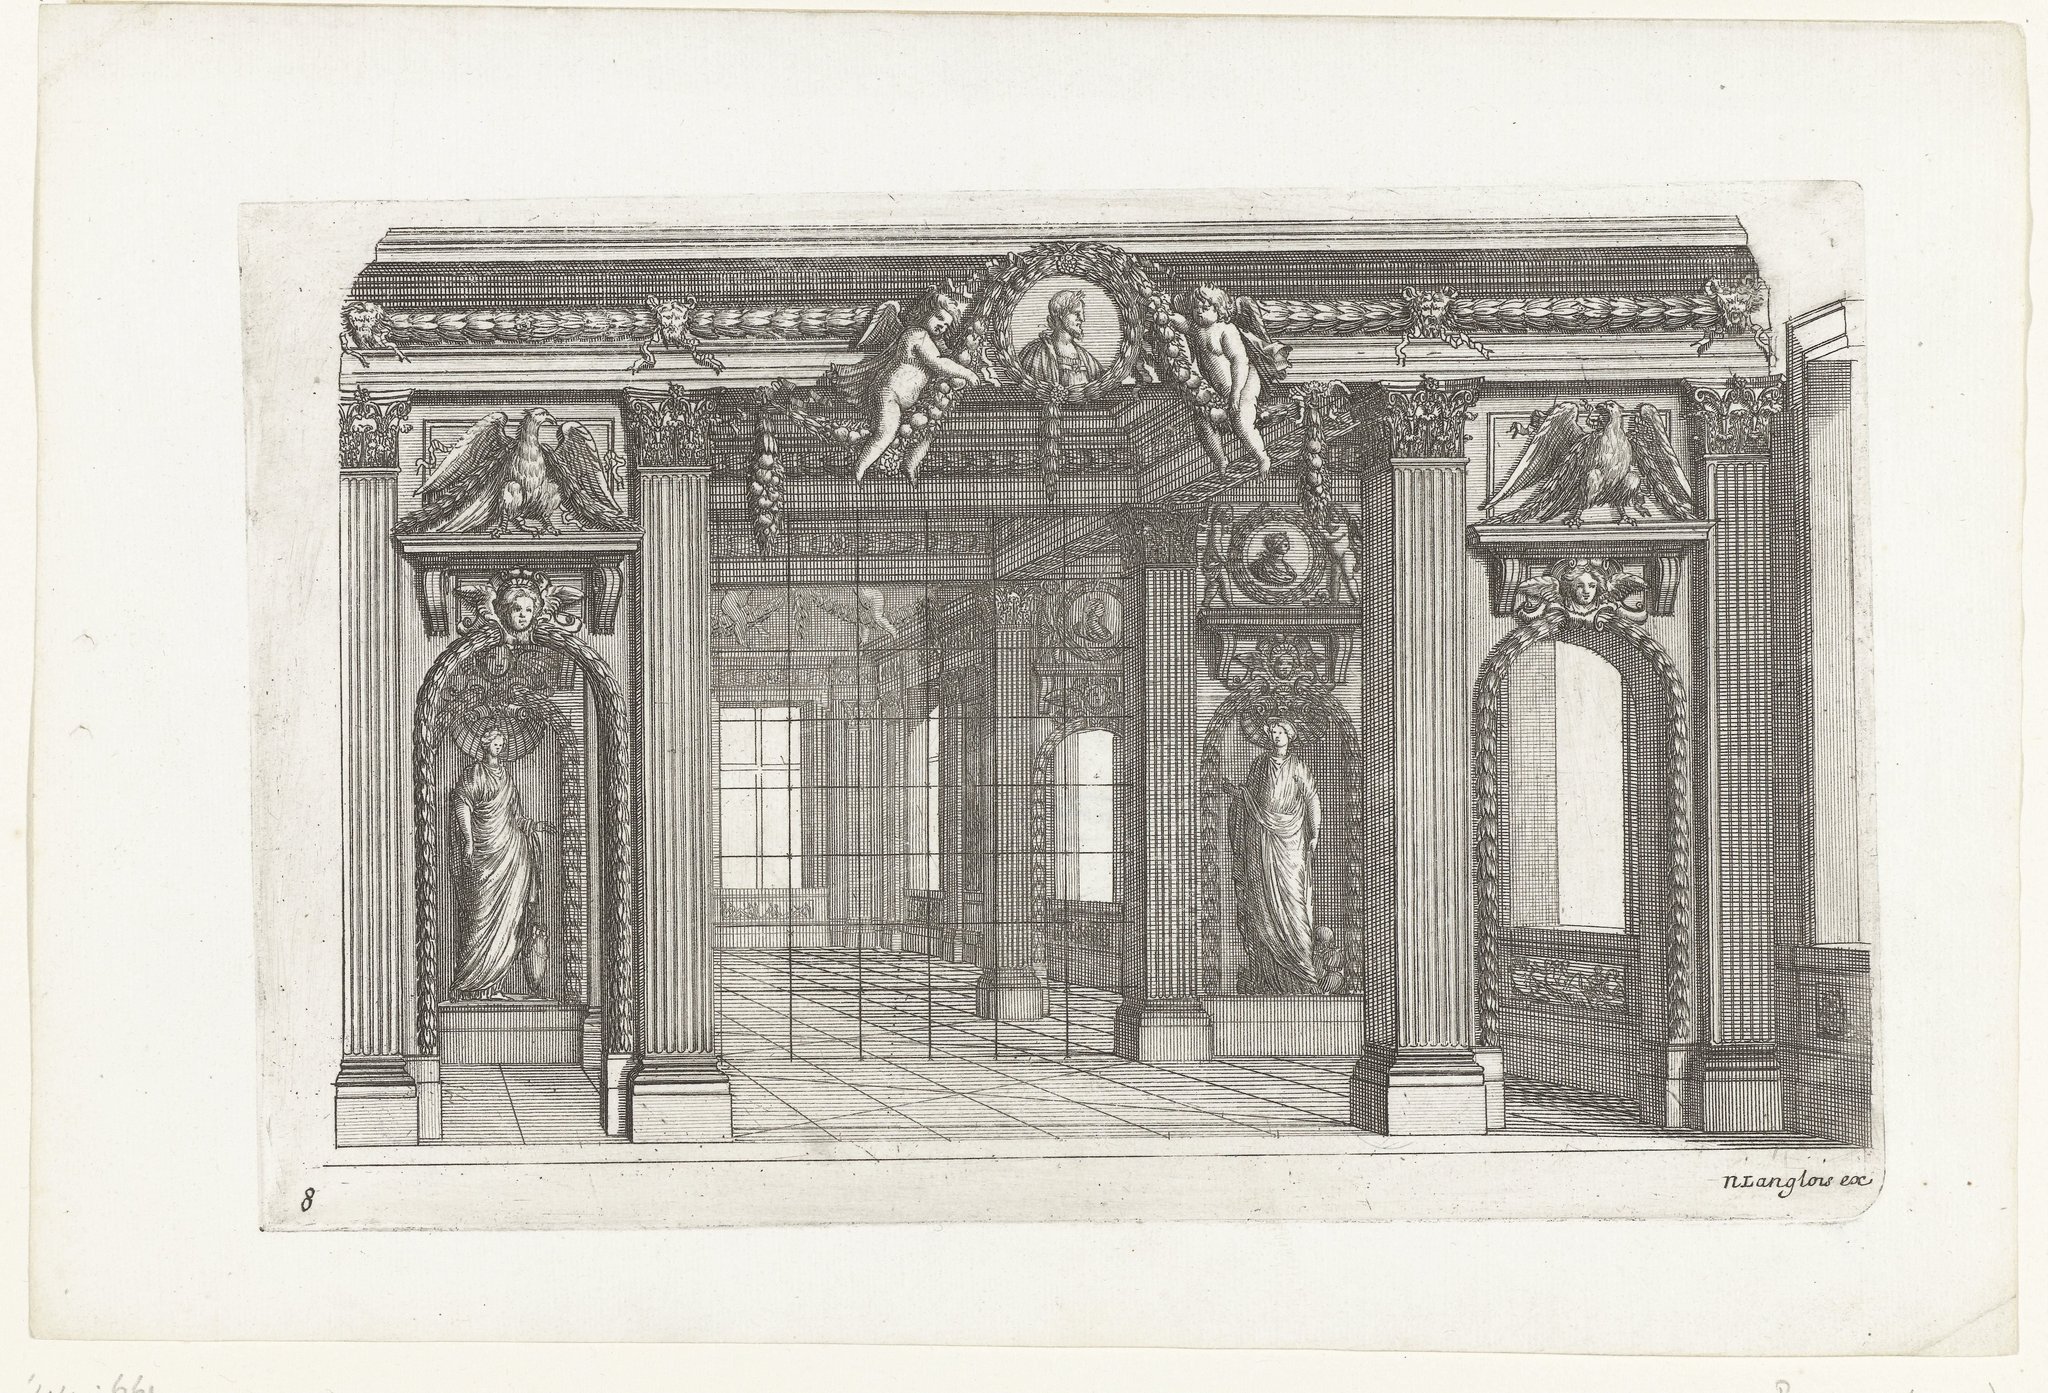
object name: print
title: Nouueaux desseins d'Alcoves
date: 1629-1703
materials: paper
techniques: engraving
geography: france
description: De muur in de alkoof bestaat uit spiegels waarin zowel de achterkant van de alkoofmuur als de tegenoverliggende muur van de kamer te zien is.